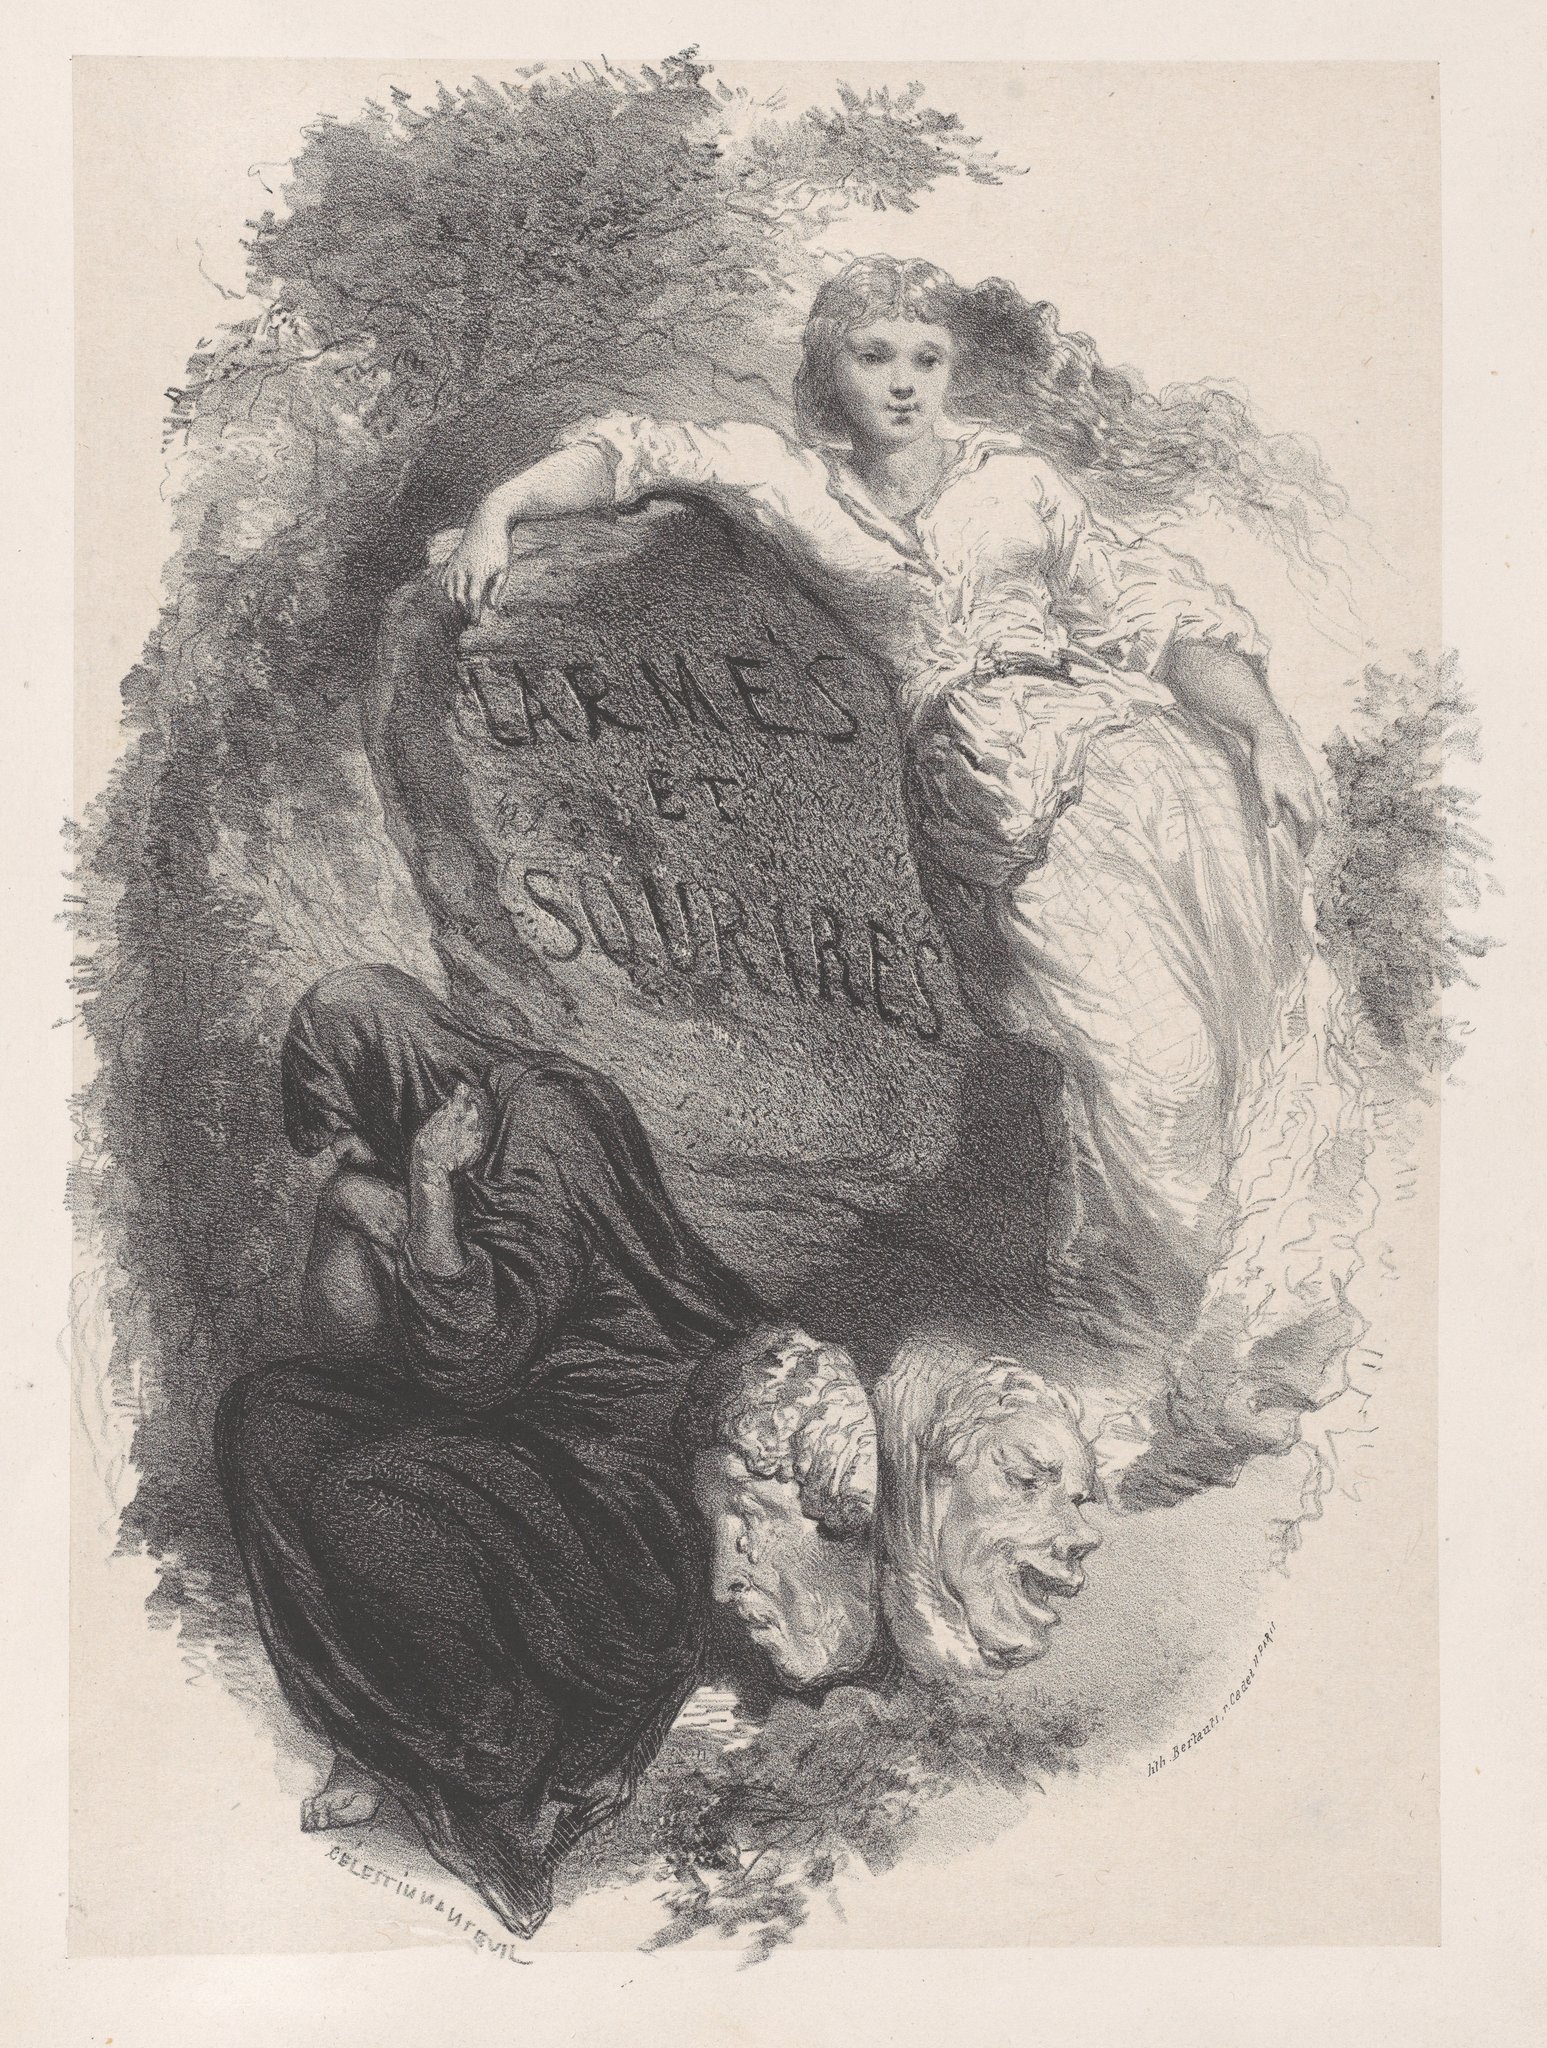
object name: print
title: Tears and Smiles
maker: célestin nanteuil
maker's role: artist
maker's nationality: french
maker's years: 1813-1873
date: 1830-1860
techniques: lithograph